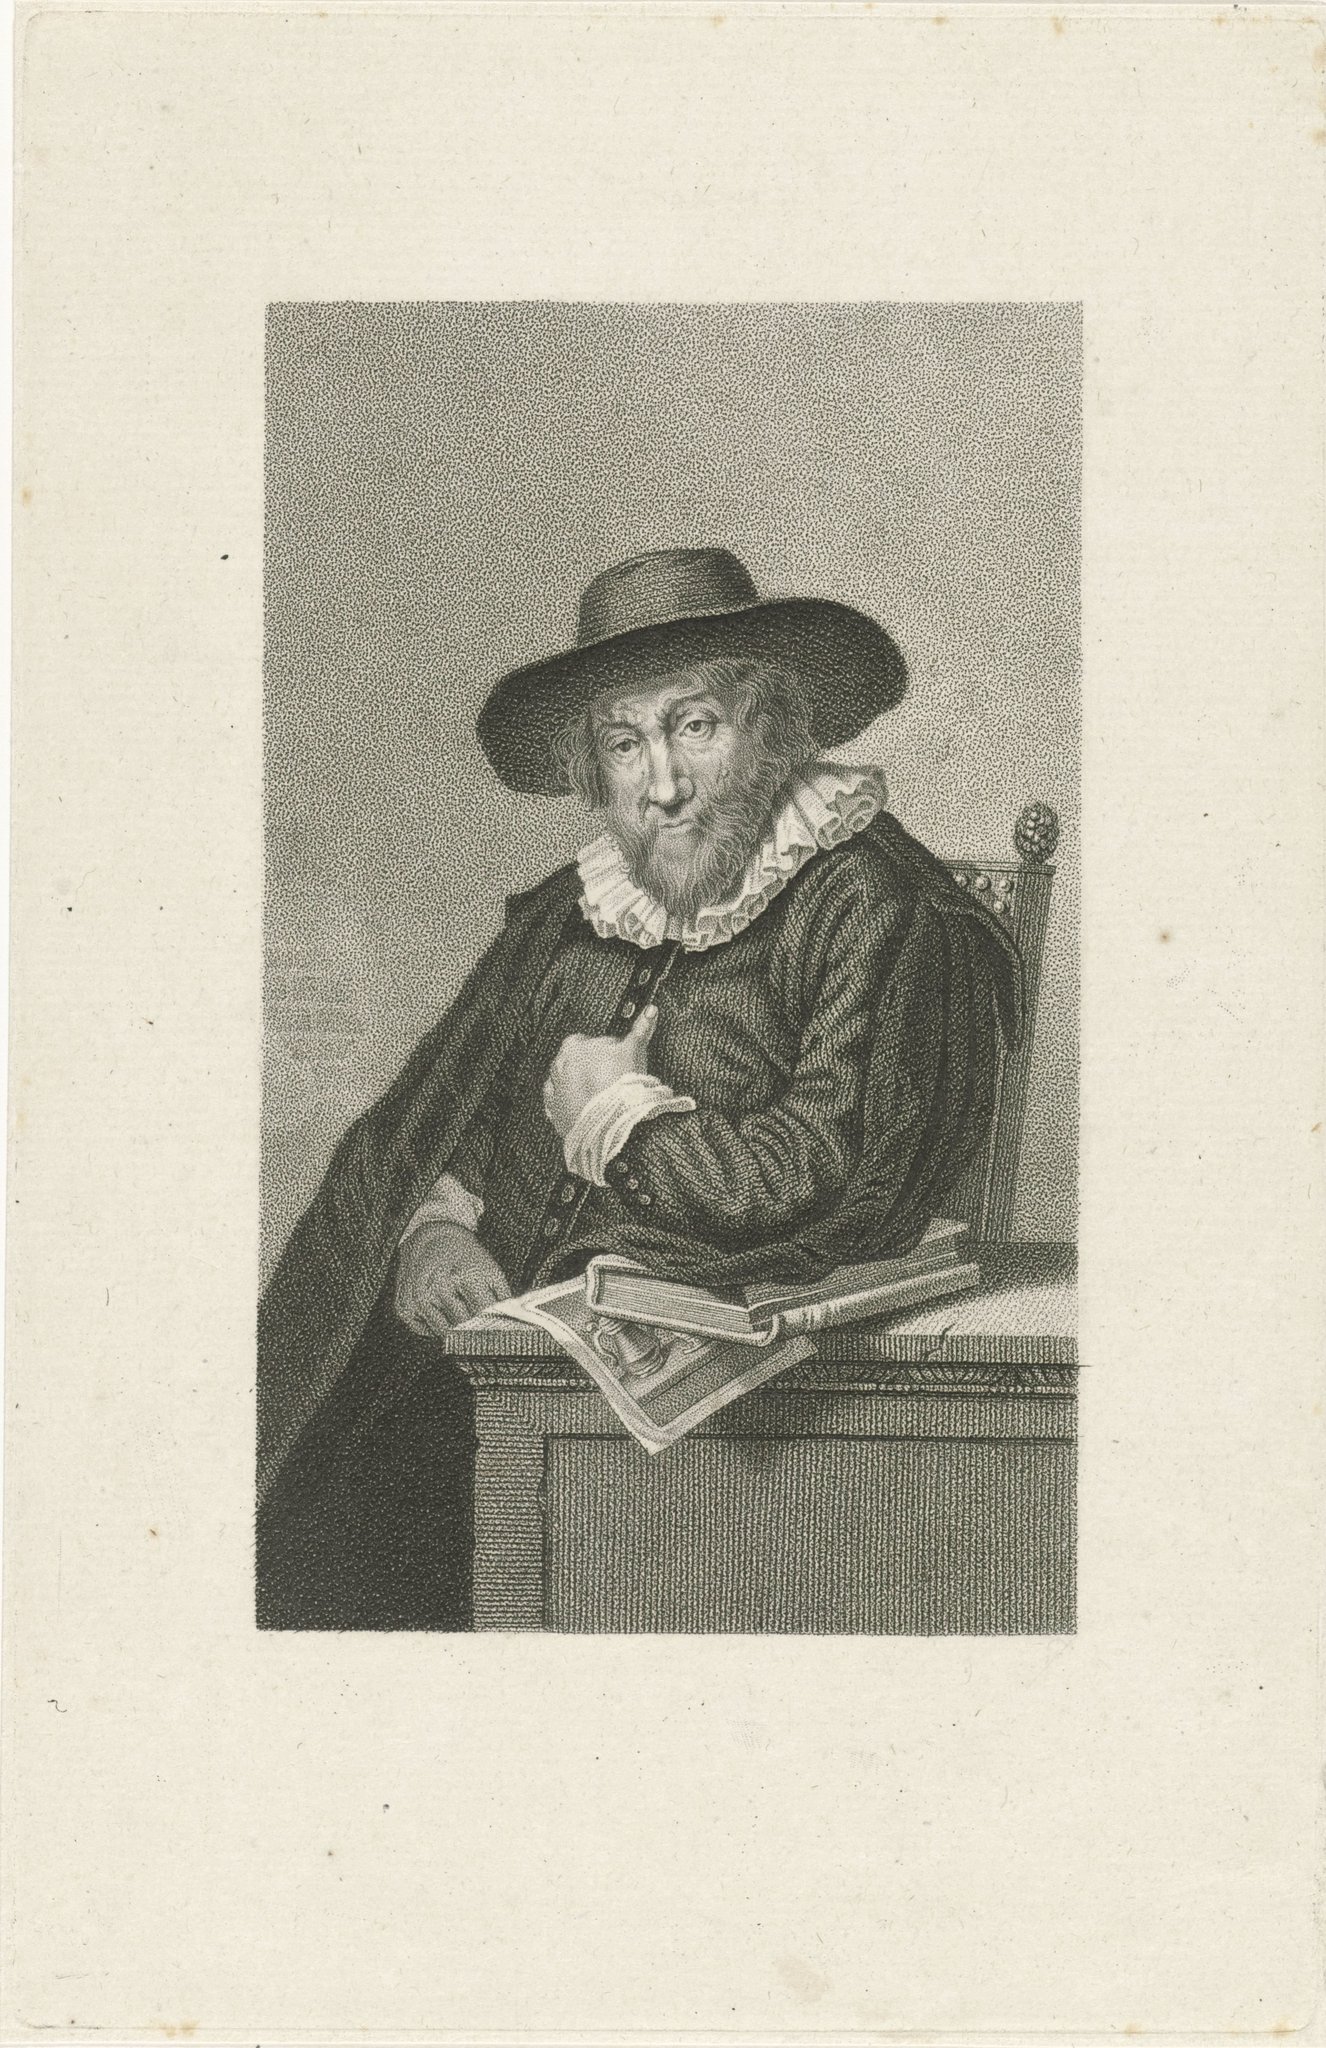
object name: print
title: Portret van Roemer Visscher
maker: pieter van der meulen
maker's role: draughtsman, painter, print maker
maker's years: 1780-1858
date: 1790-1858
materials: paper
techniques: stippled etching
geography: amsterdam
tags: roemer visscher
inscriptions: collector's mark: Lugt 2228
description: Portret van koopman en dichter Roemer Visscher op 71-jarige leeftijd, zittend bij een tafel.